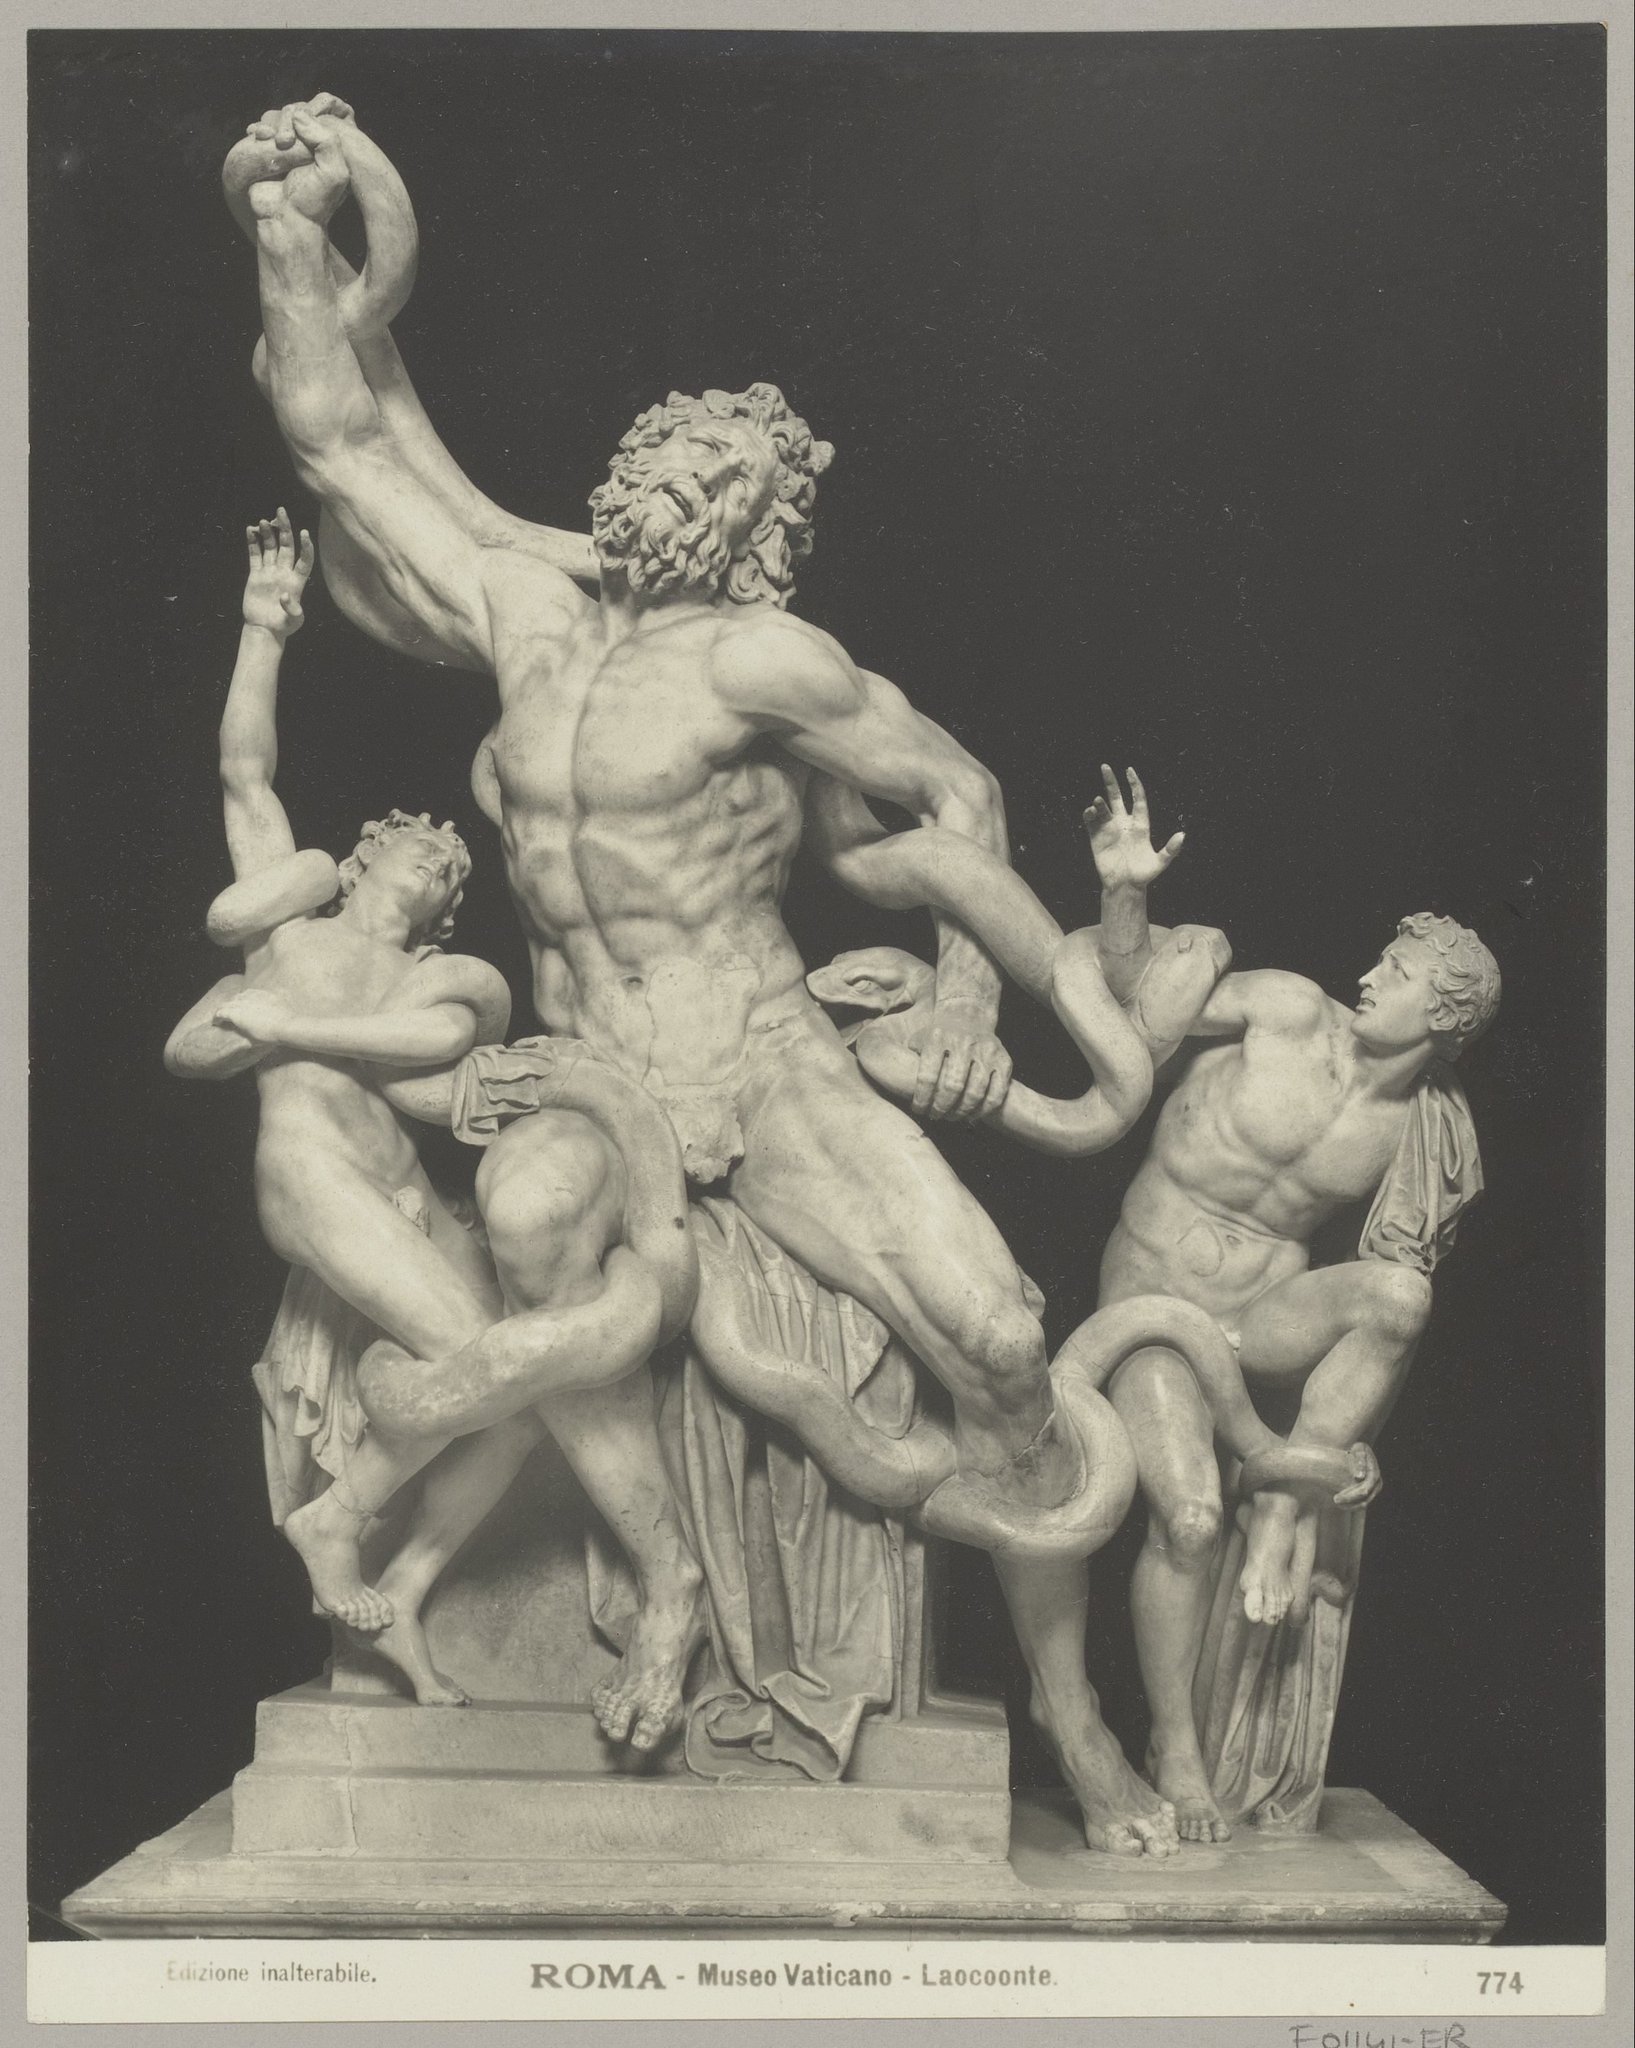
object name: photograph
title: ROMA - Museo Vaticano - Laocoonte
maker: Anonymous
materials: photographic support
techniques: gelatin silver print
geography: vatican city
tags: laocoon and his twin sons are strangled by two serpents during the preparations for a sacrifice, piece of sculpture, reproduction of a piece of sculpture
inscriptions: inscription: ‘Edizione inalterabile’, number: ‘774’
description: Onderdeel van Fotoalbum van een reis door Zuid-Europa en het Midden-Oosten.